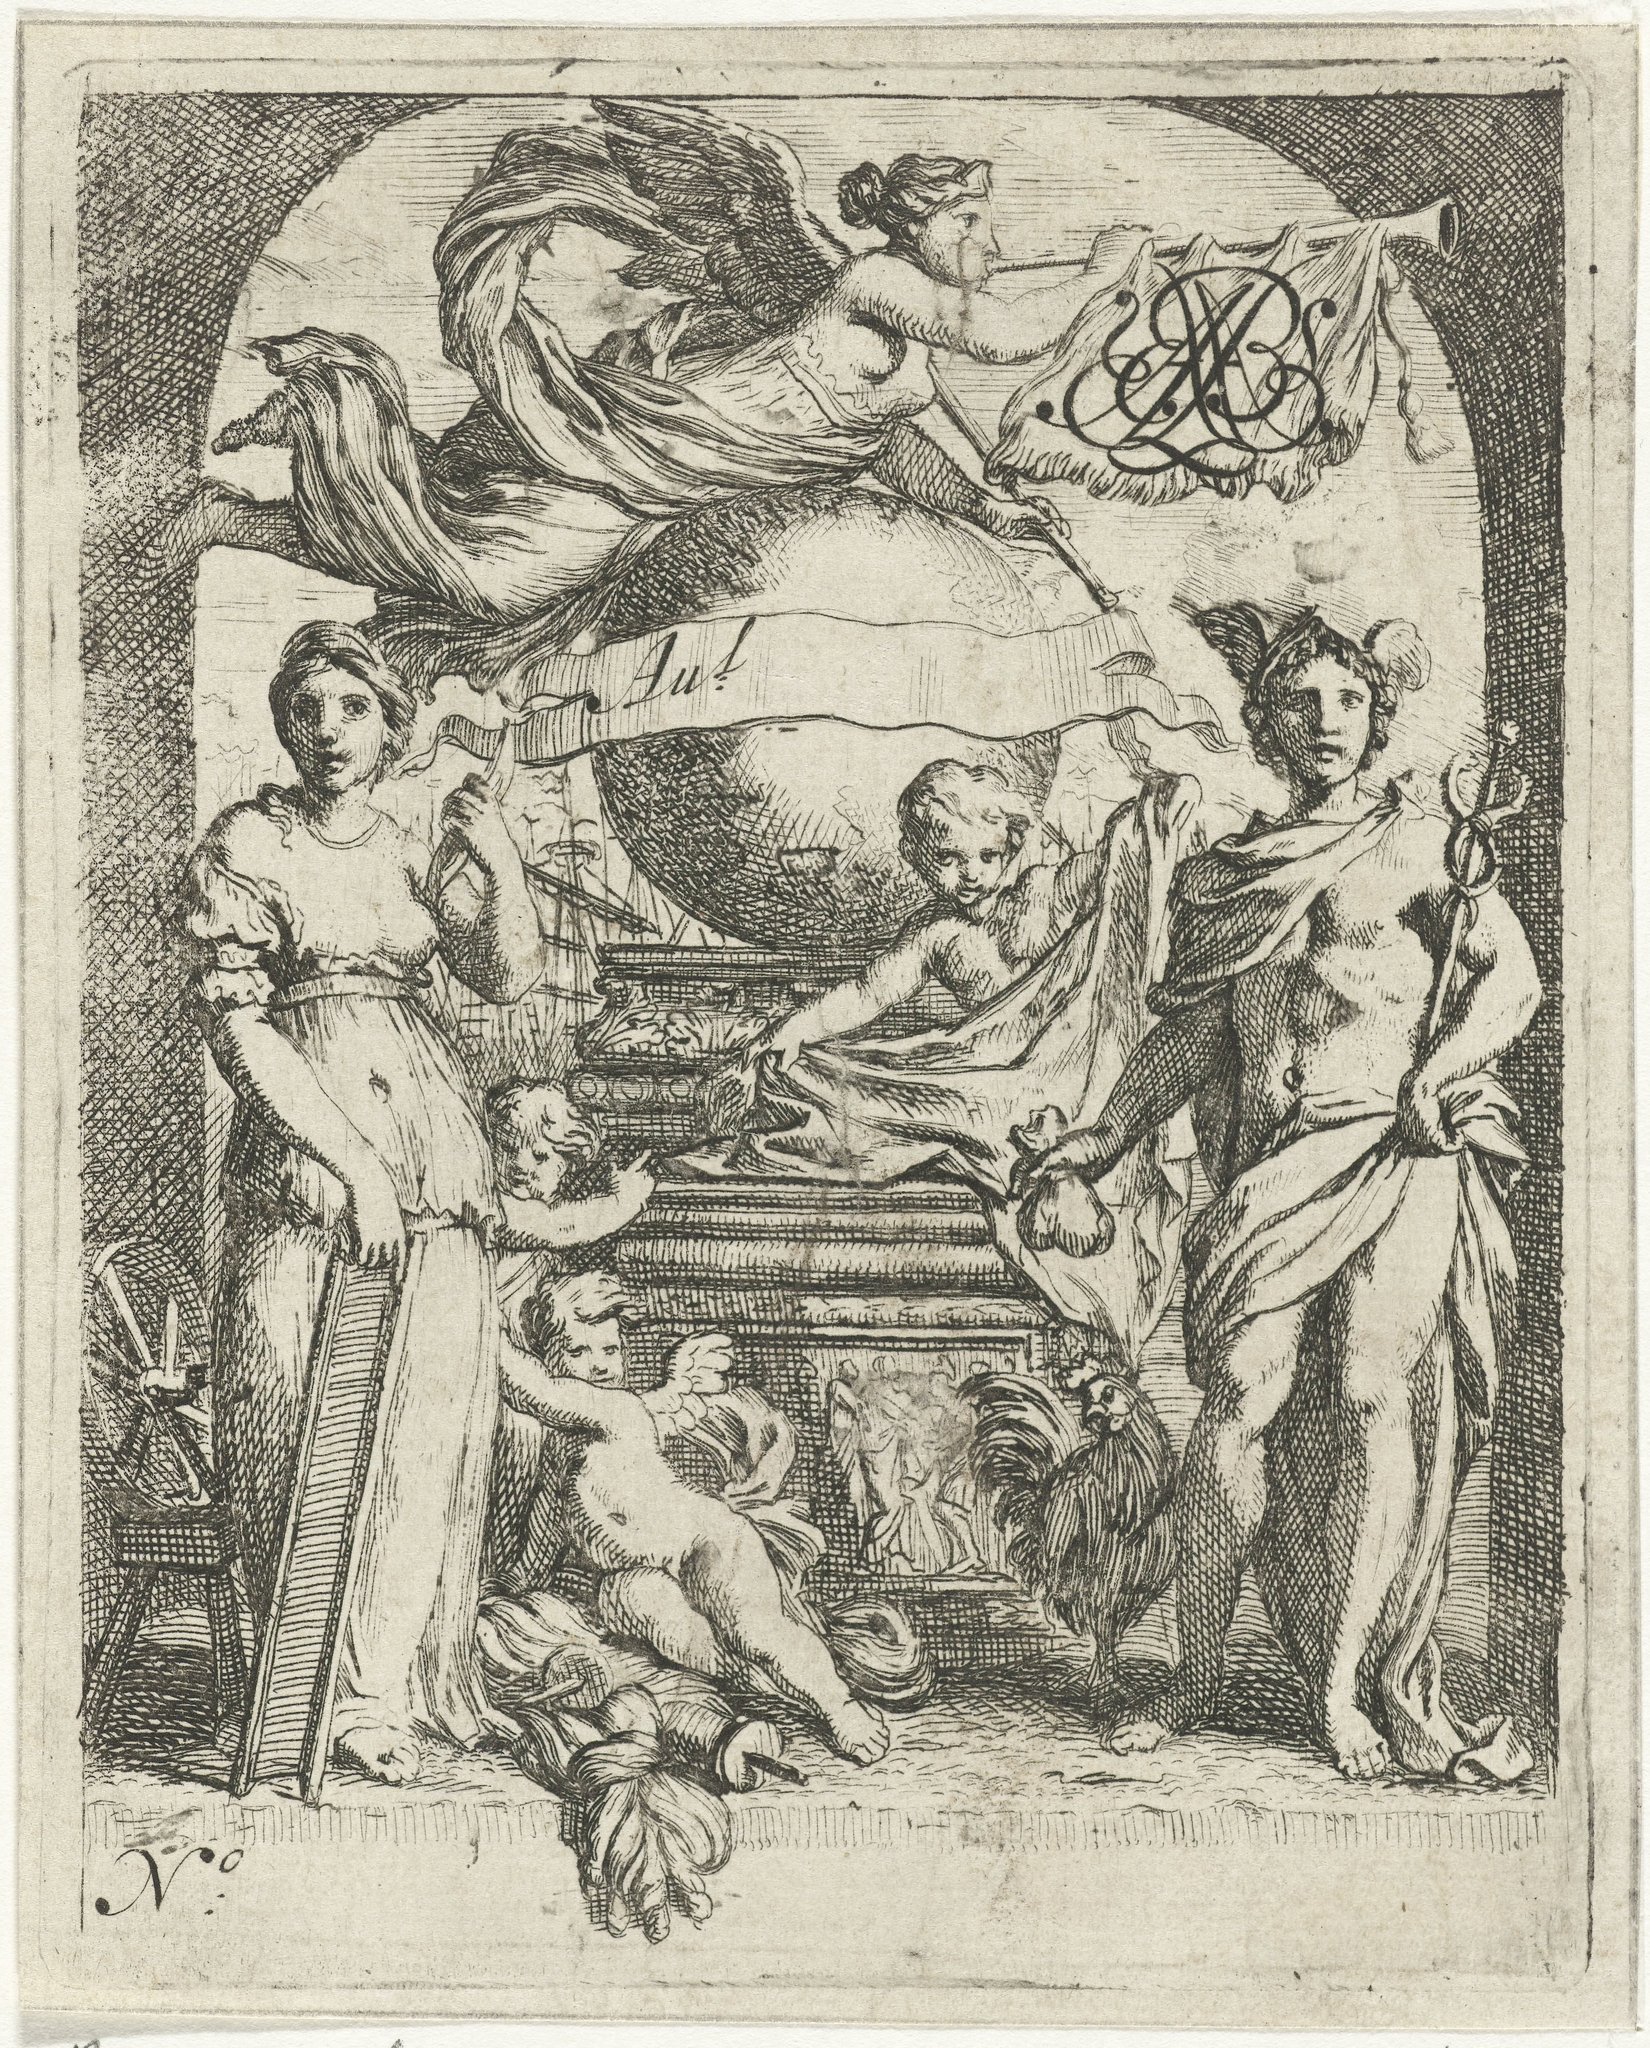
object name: print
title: Mercurius en de Weefkunst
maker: gerard de lairesse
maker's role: draughtsman, painter, print maker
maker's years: 1641-1711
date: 1675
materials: paper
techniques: etching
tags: personification of (art) academy; 'academia' (ripa) (+ tapestry weaving, gobelin making), (story of) mercury (hermes), fame; 'fama', 'fama buona', 'fama chiara' (ripa), allegory of trade; 'commertio della vita humana' (ripa)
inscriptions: collector's mark: Lugt 2228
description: Vergezeld door putti flankeren Mercurius, god van de handel, en de personificatie van de weefkunst een op een voetstuk geplaatste bol met banderol. In de lucht vliegt de bazuin blazende Faam. Op de achtergrond zijn masten van zeilschepen zichtbaar. Prent linksonder gemerkt: No.